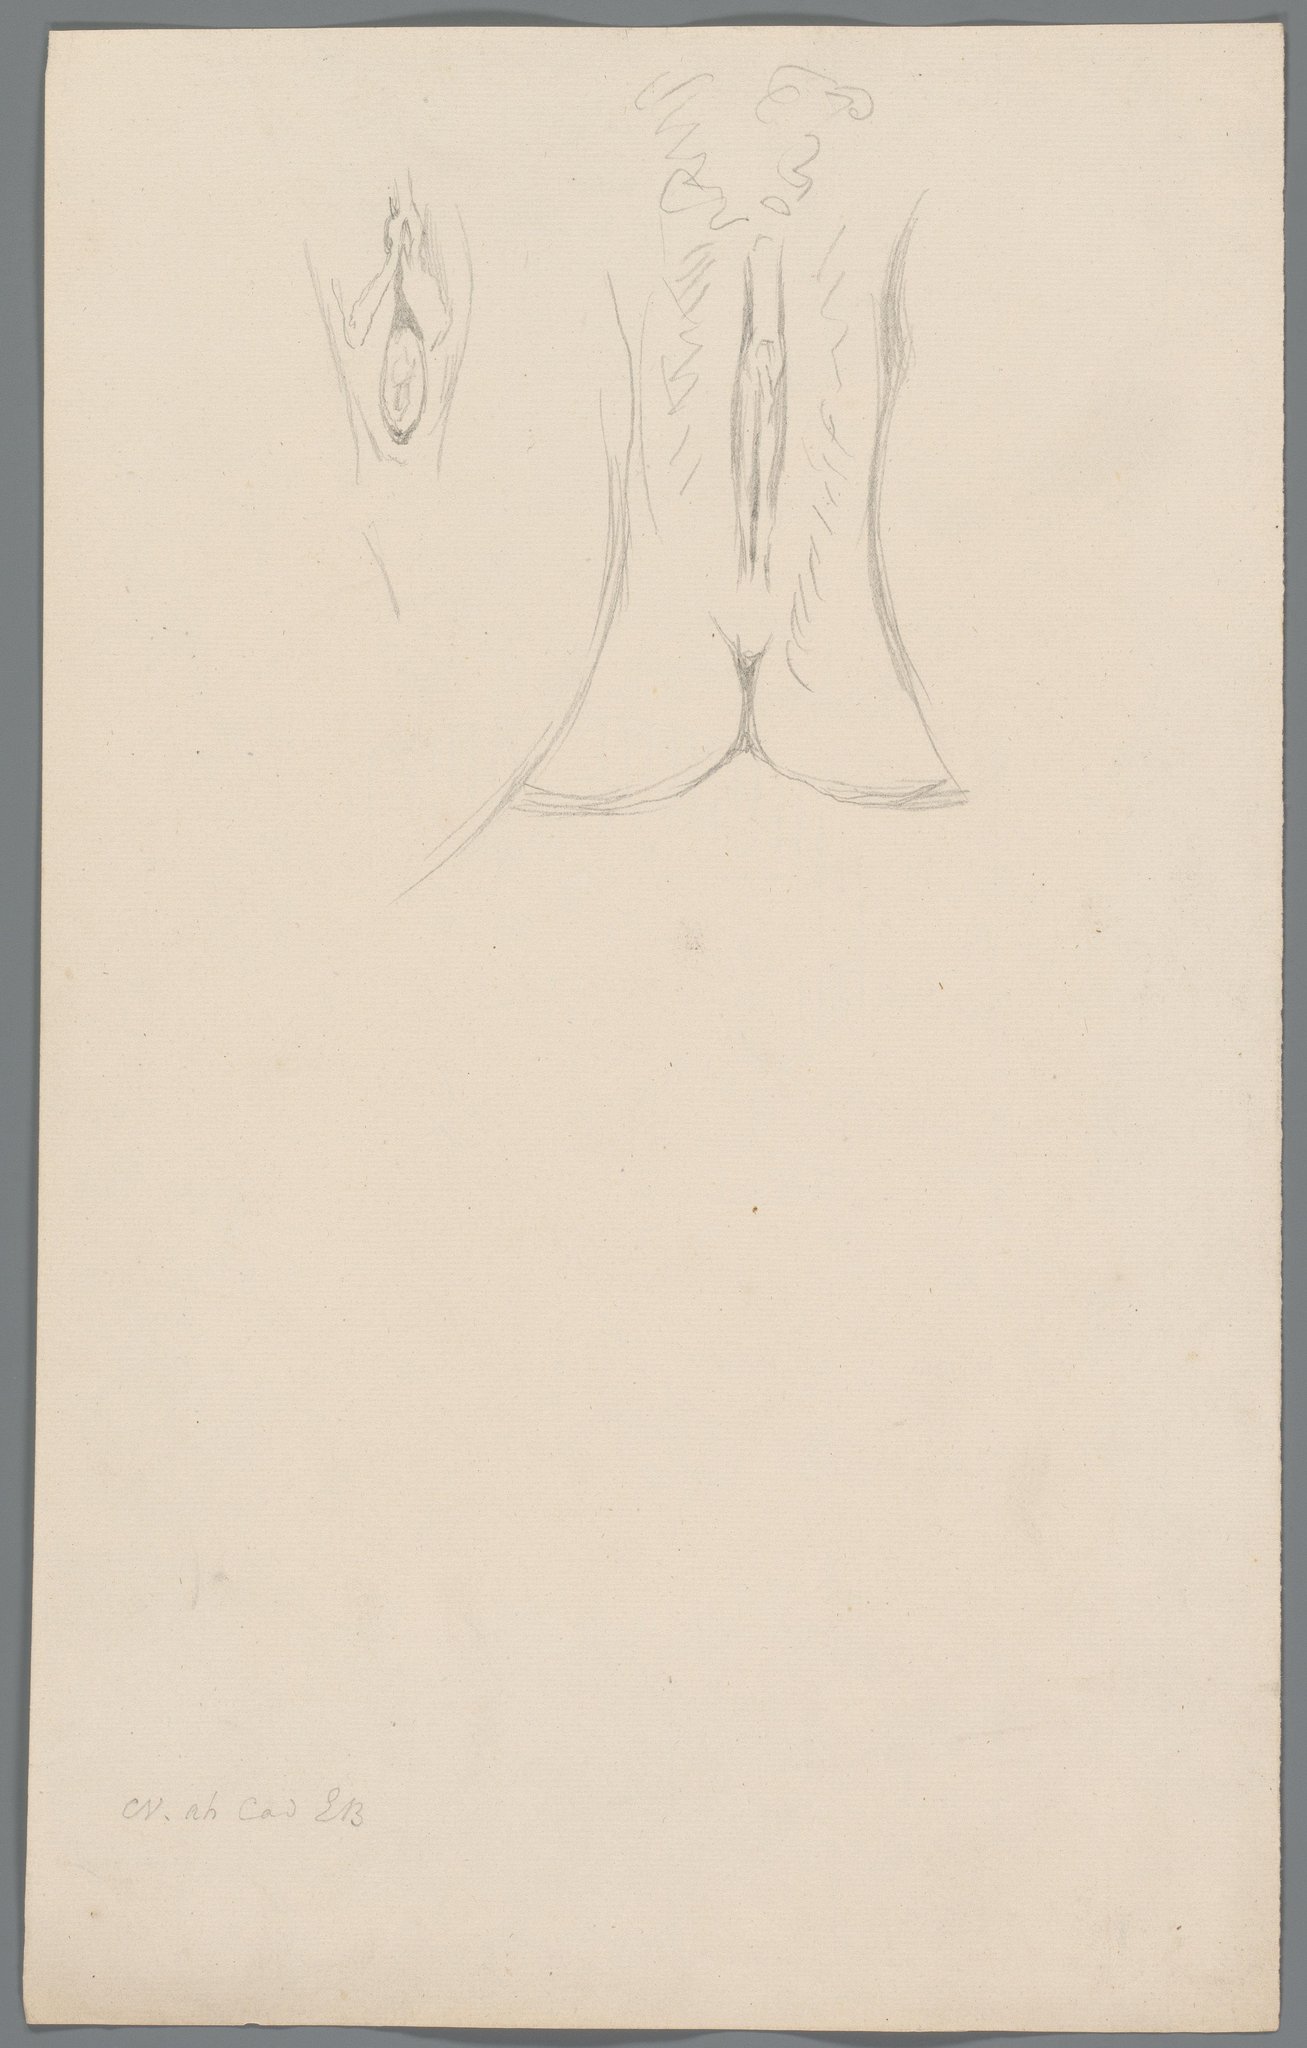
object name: drawing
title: Studie van een vulva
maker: jacobus everhardus josephus van den berg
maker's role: draughtsman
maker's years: 1802-1861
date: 1852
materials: paper, pencil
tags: female sexual organs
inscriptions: inscription: ‘CV ab Cad EB’